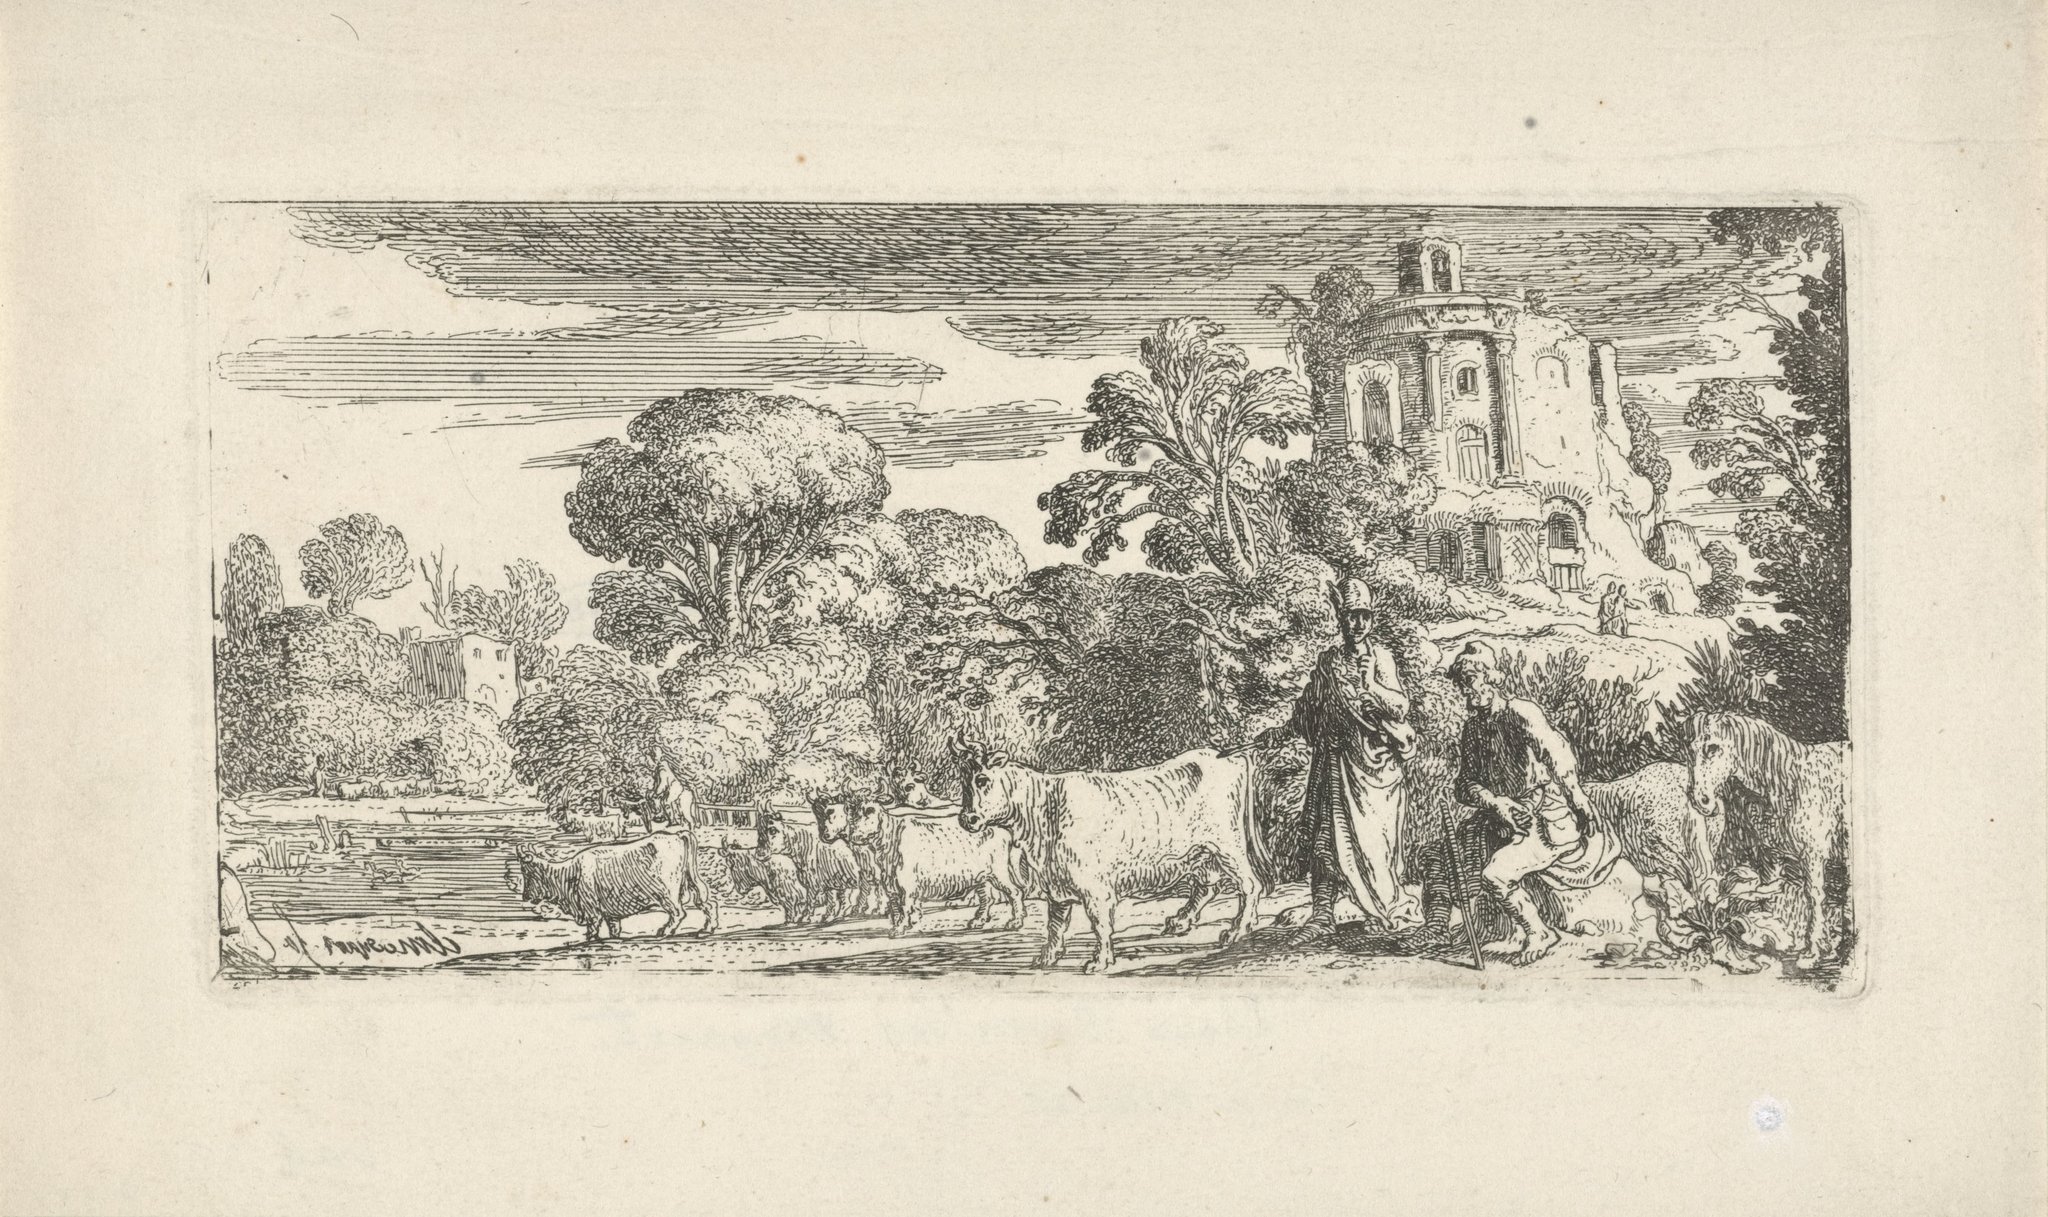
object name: print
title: Mercurius en Battus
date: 1612-1655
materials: paper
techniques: etching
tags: mercury and battus; battus is bribed with a heifer as hush-money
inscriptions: collector's mark: Lugt 2228, collector's mark: Lugt 2760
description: Mercurius steelt het vee van Apollo en draagt de oude boer Battus op, die de diefstal ziet, om te zwijgen. Rechts op de achtergrond een ronde ruïne.